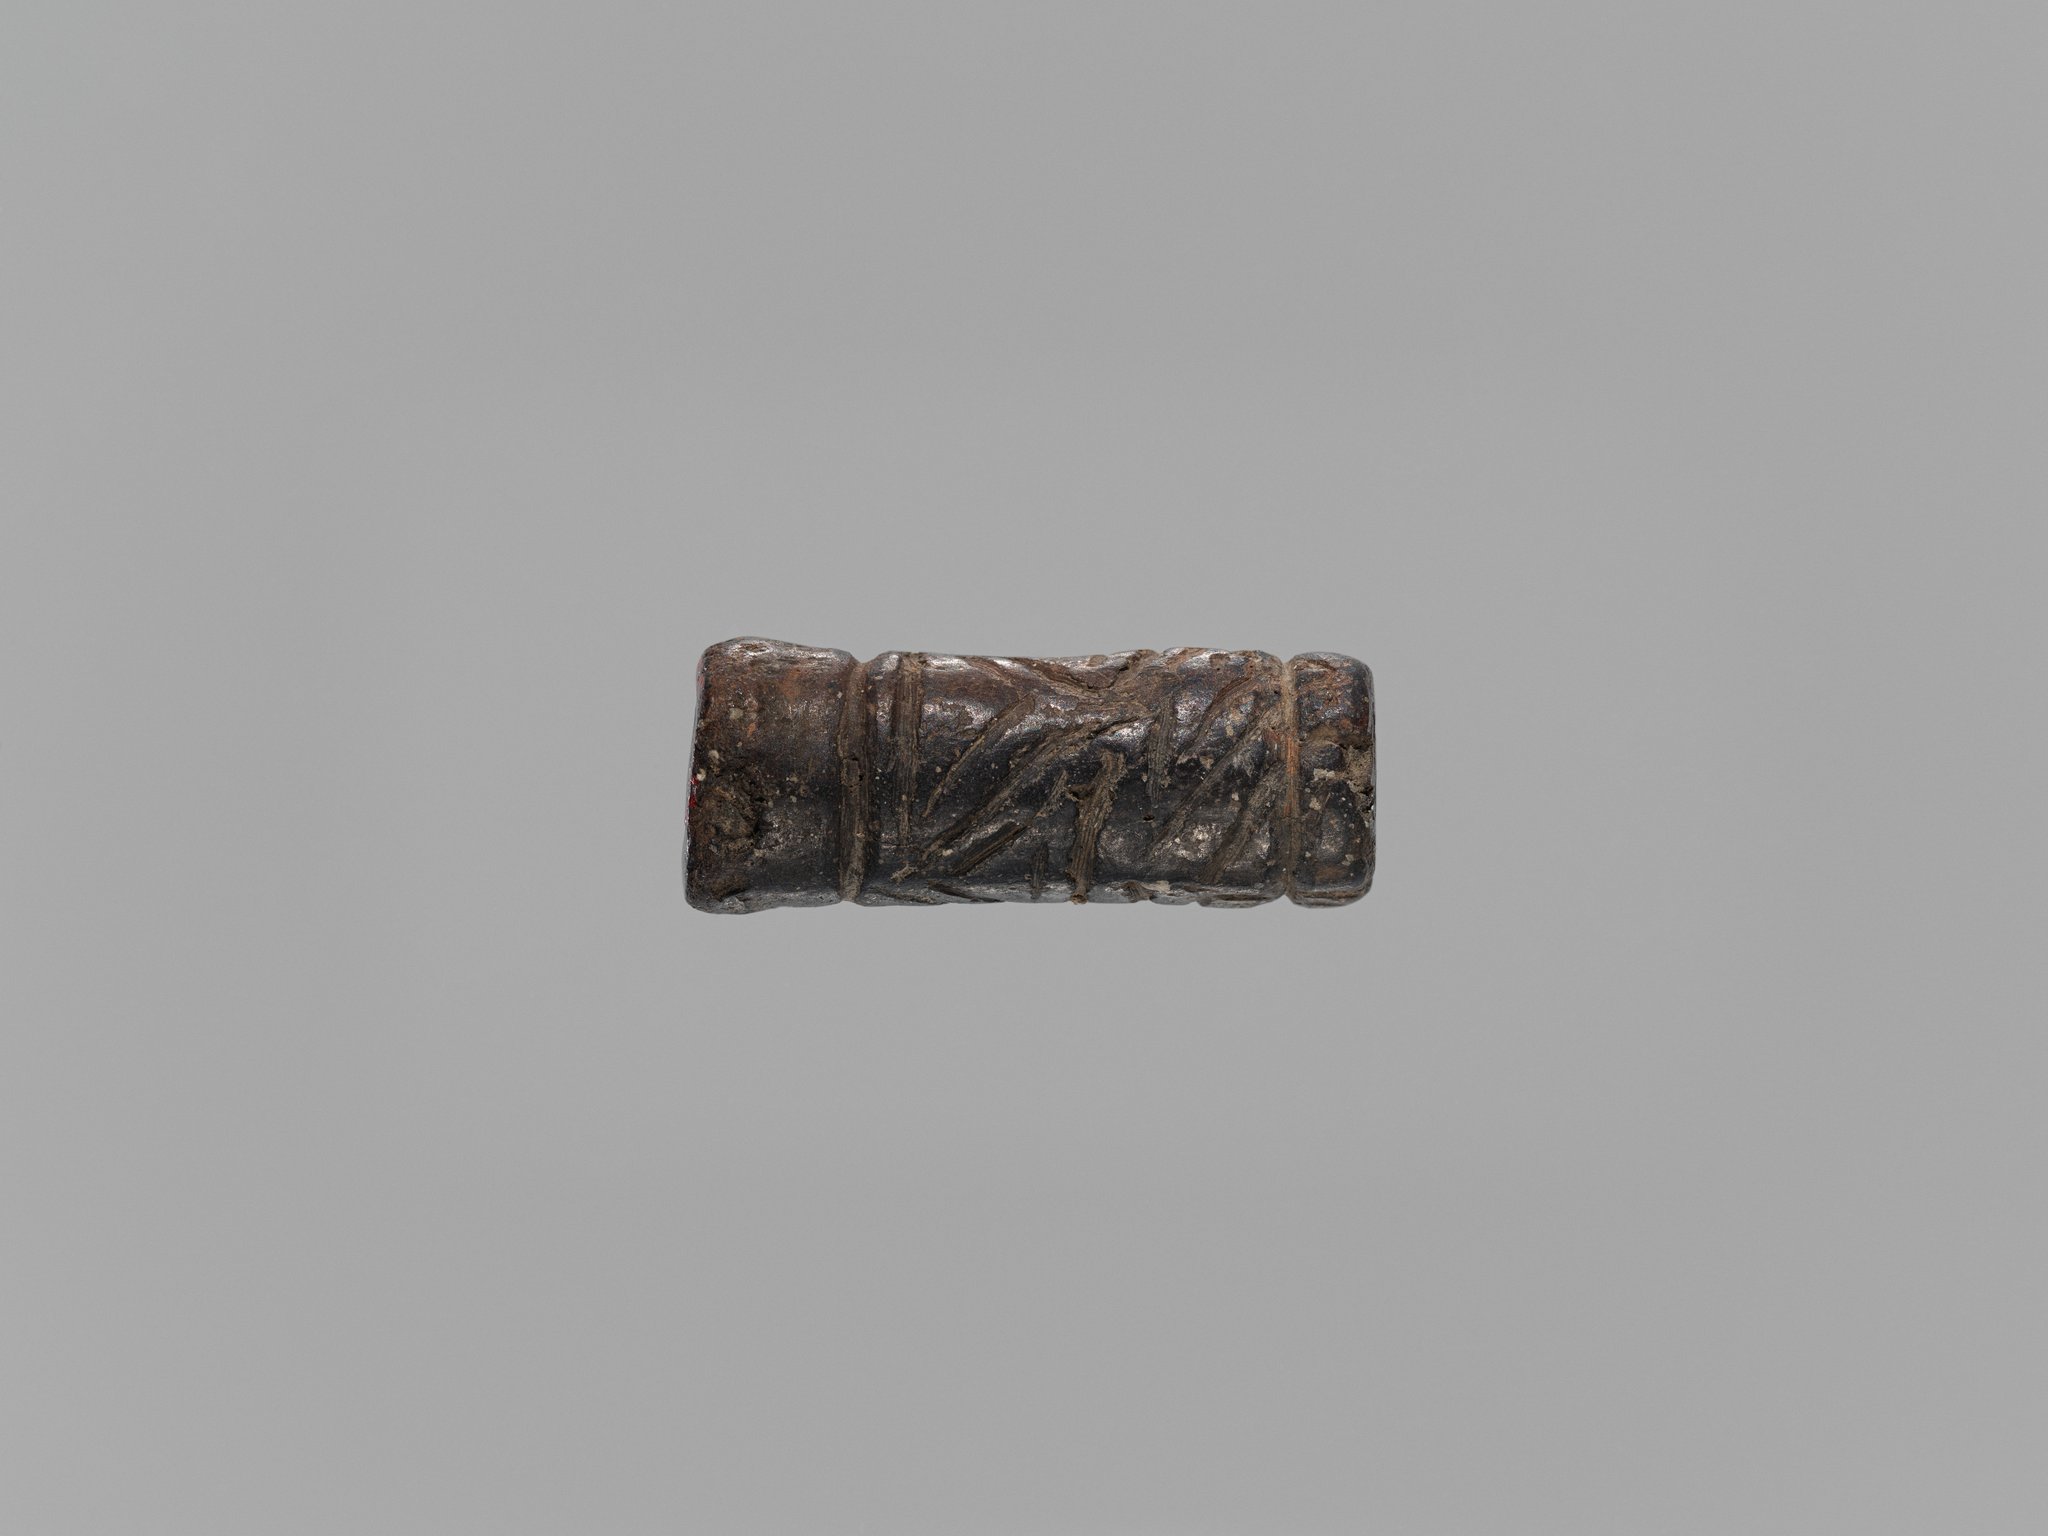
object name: ear ornament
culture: taíno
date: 901-1500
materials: ceramic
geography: dominican republic